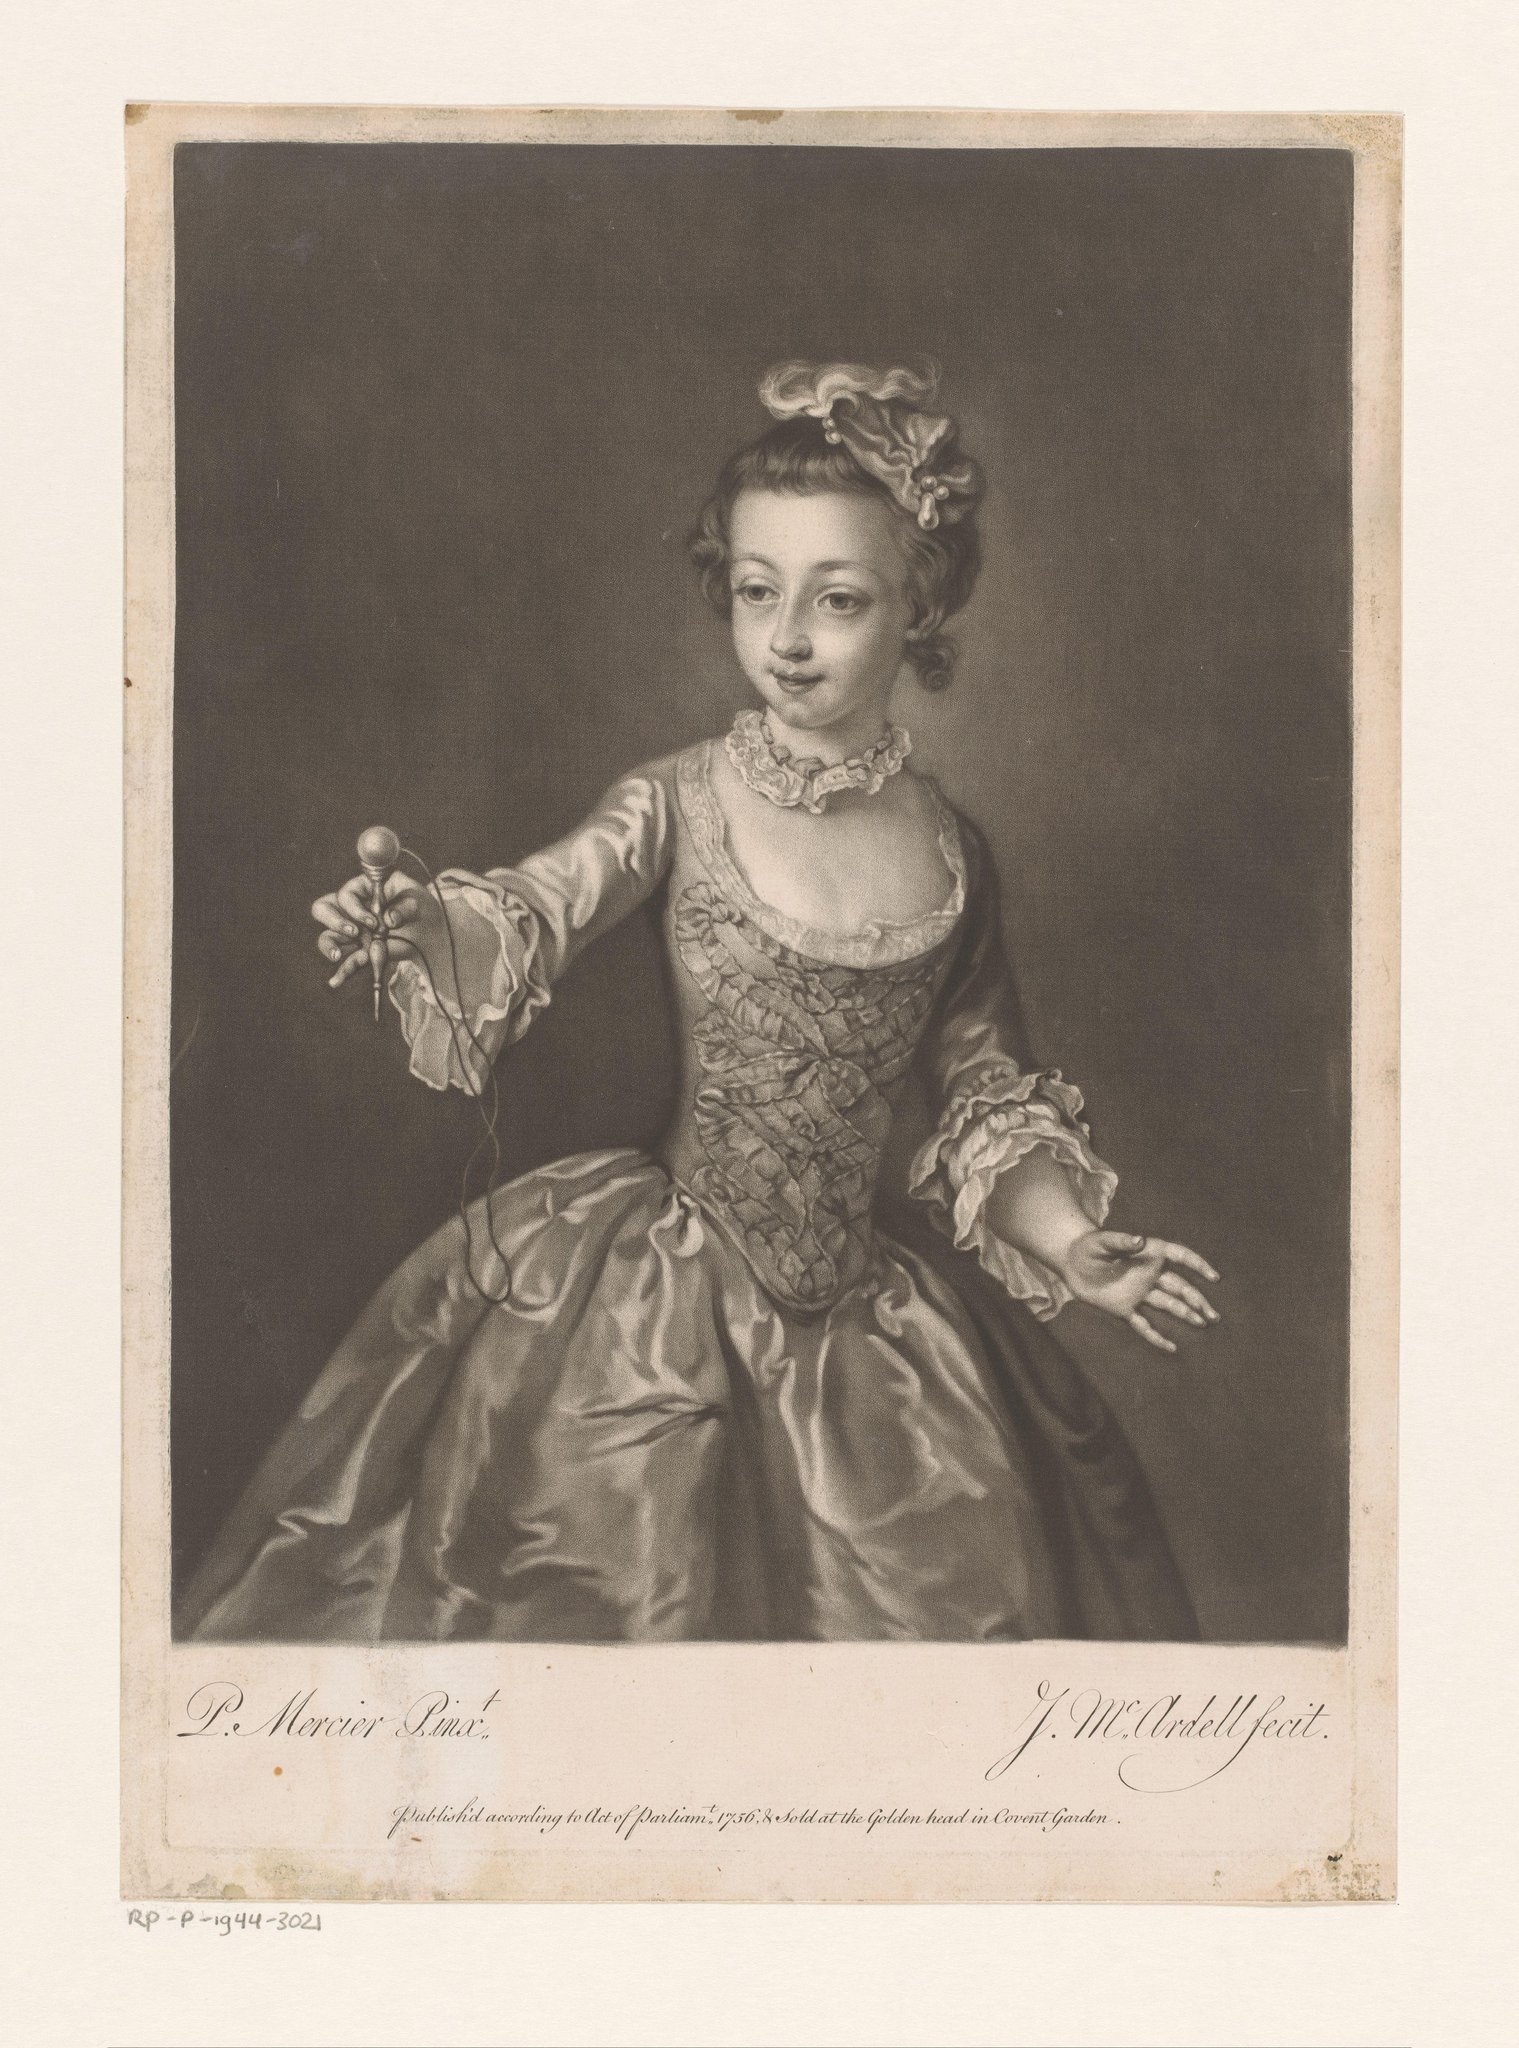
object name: print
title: Portret van een meisje met bilboquet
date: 1756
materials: paper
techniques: mezzotint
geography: london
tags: painter, charlotte mercier, cup-and-ball, bilboquet, anonymous historical person portrayed alone - bb - woman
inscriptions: collector's mark: Lugt 2228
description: Chaloner Smith beschrijft dit als een portret van Charlotte Mercier.